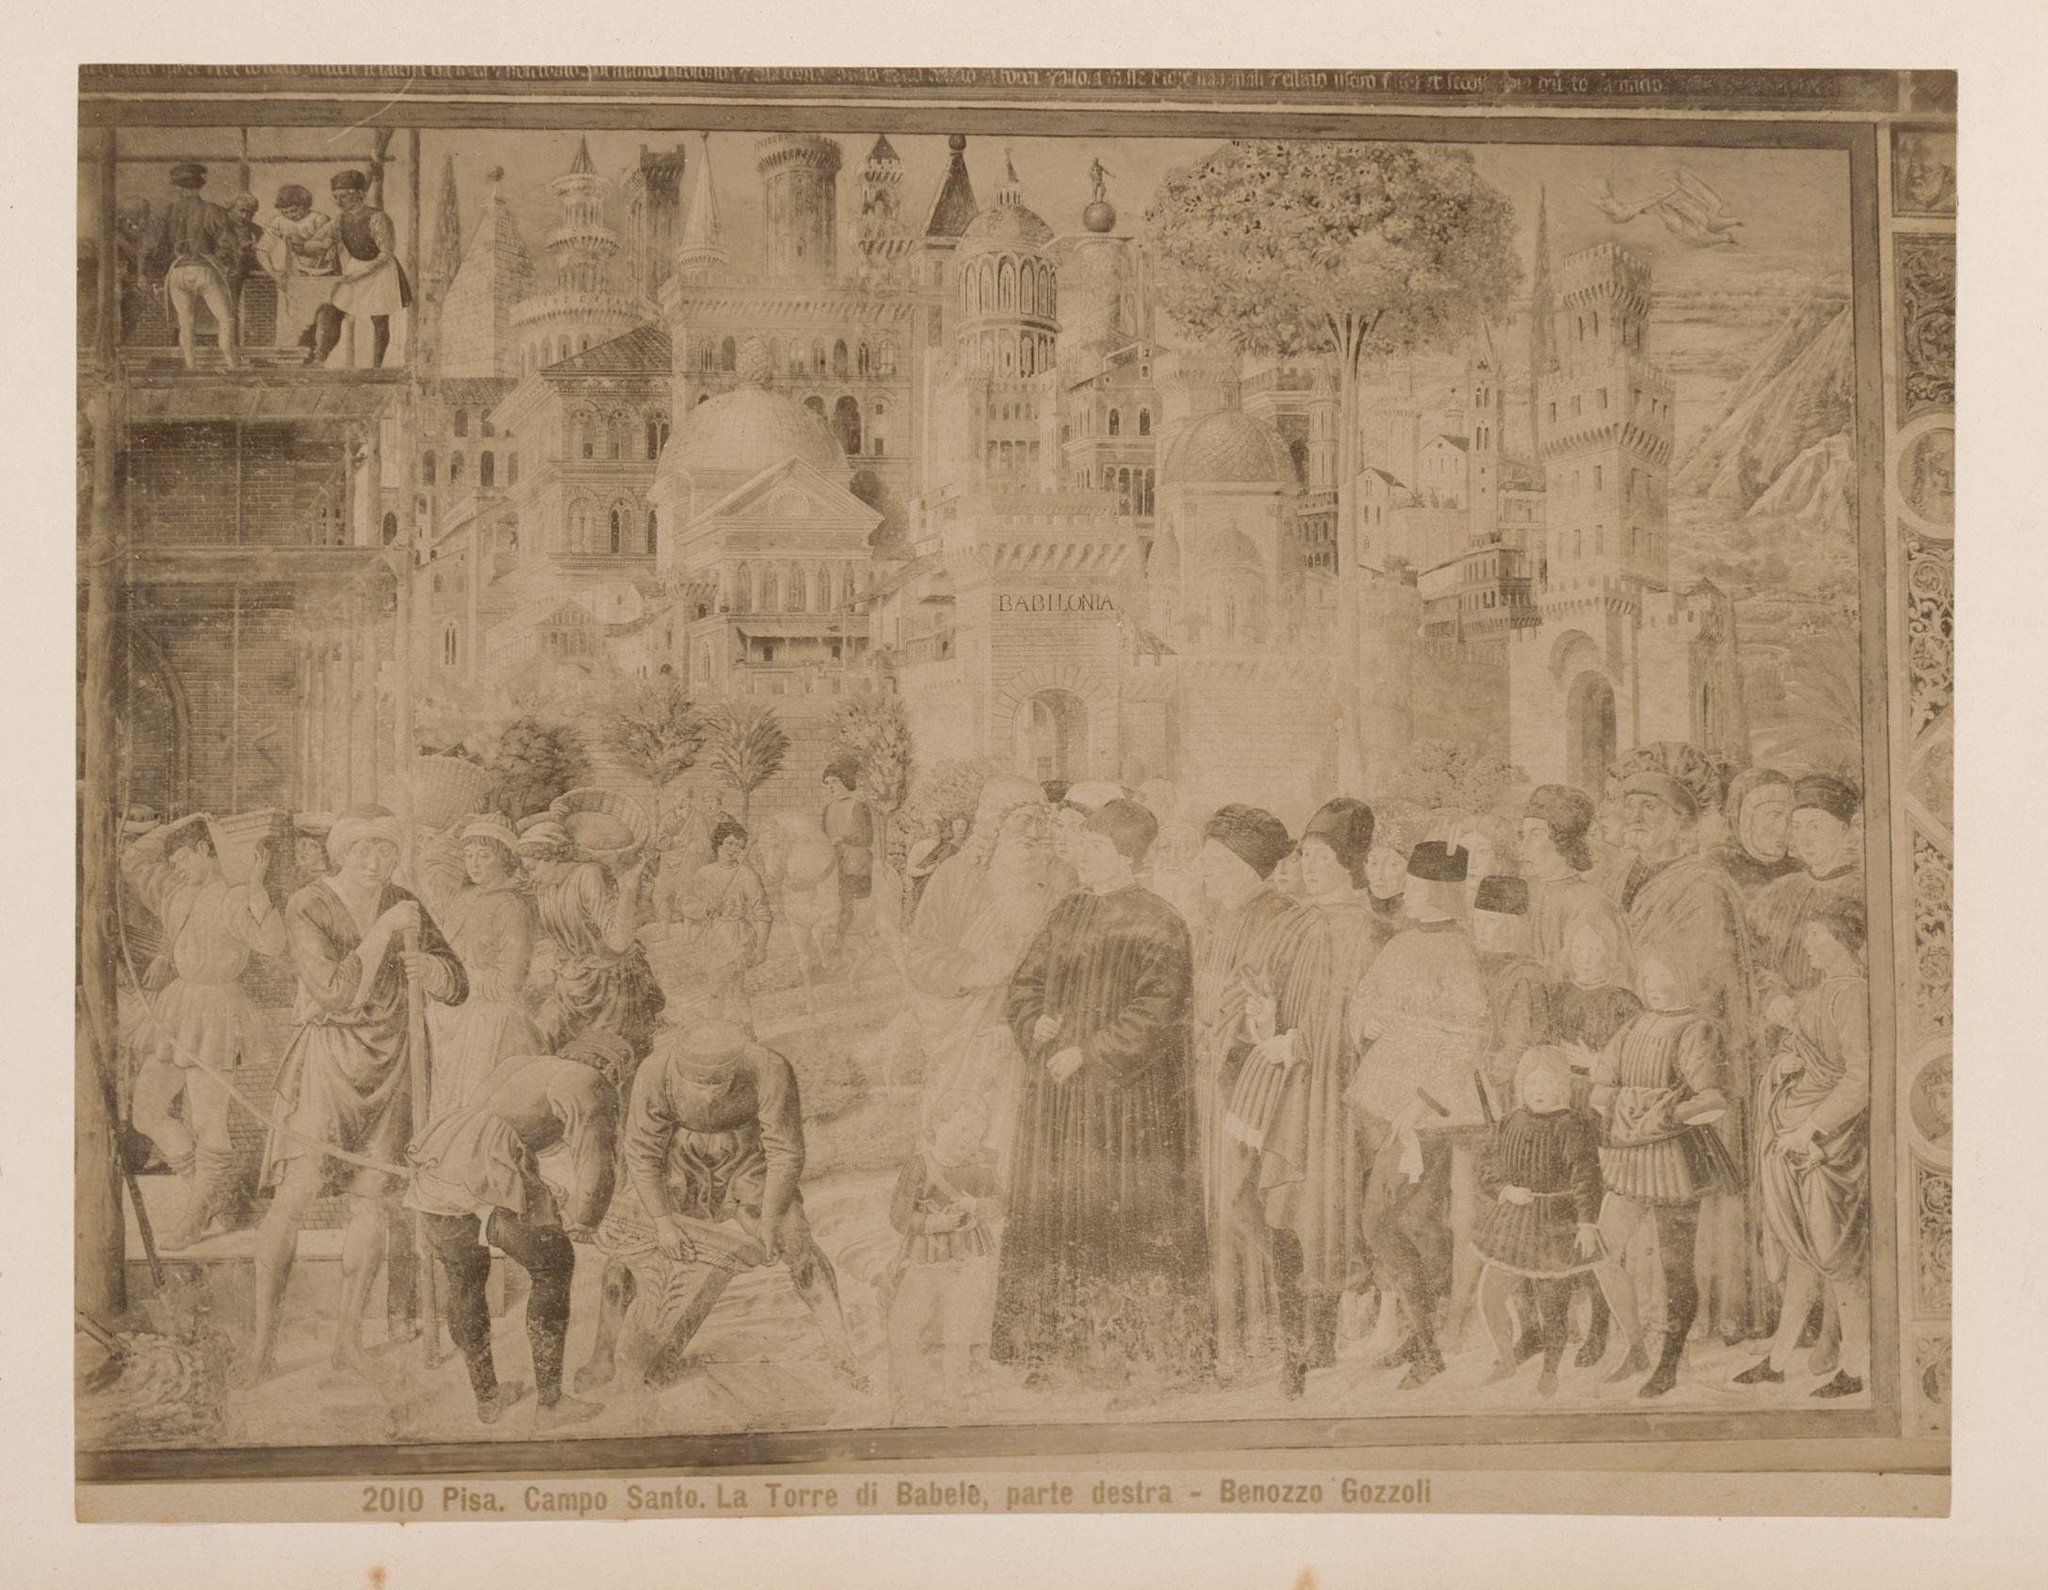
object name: reproduction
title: Fotoreproductie van het rechterdeel van het fresco De toren van Babel naar Benozzo Gozzoli, in het Camposanto te Pisa, Italië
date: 1860-1881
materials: paper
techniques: albumen print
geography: pisa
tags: the tower of babel, picture, painting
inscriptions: number: ‘2010’